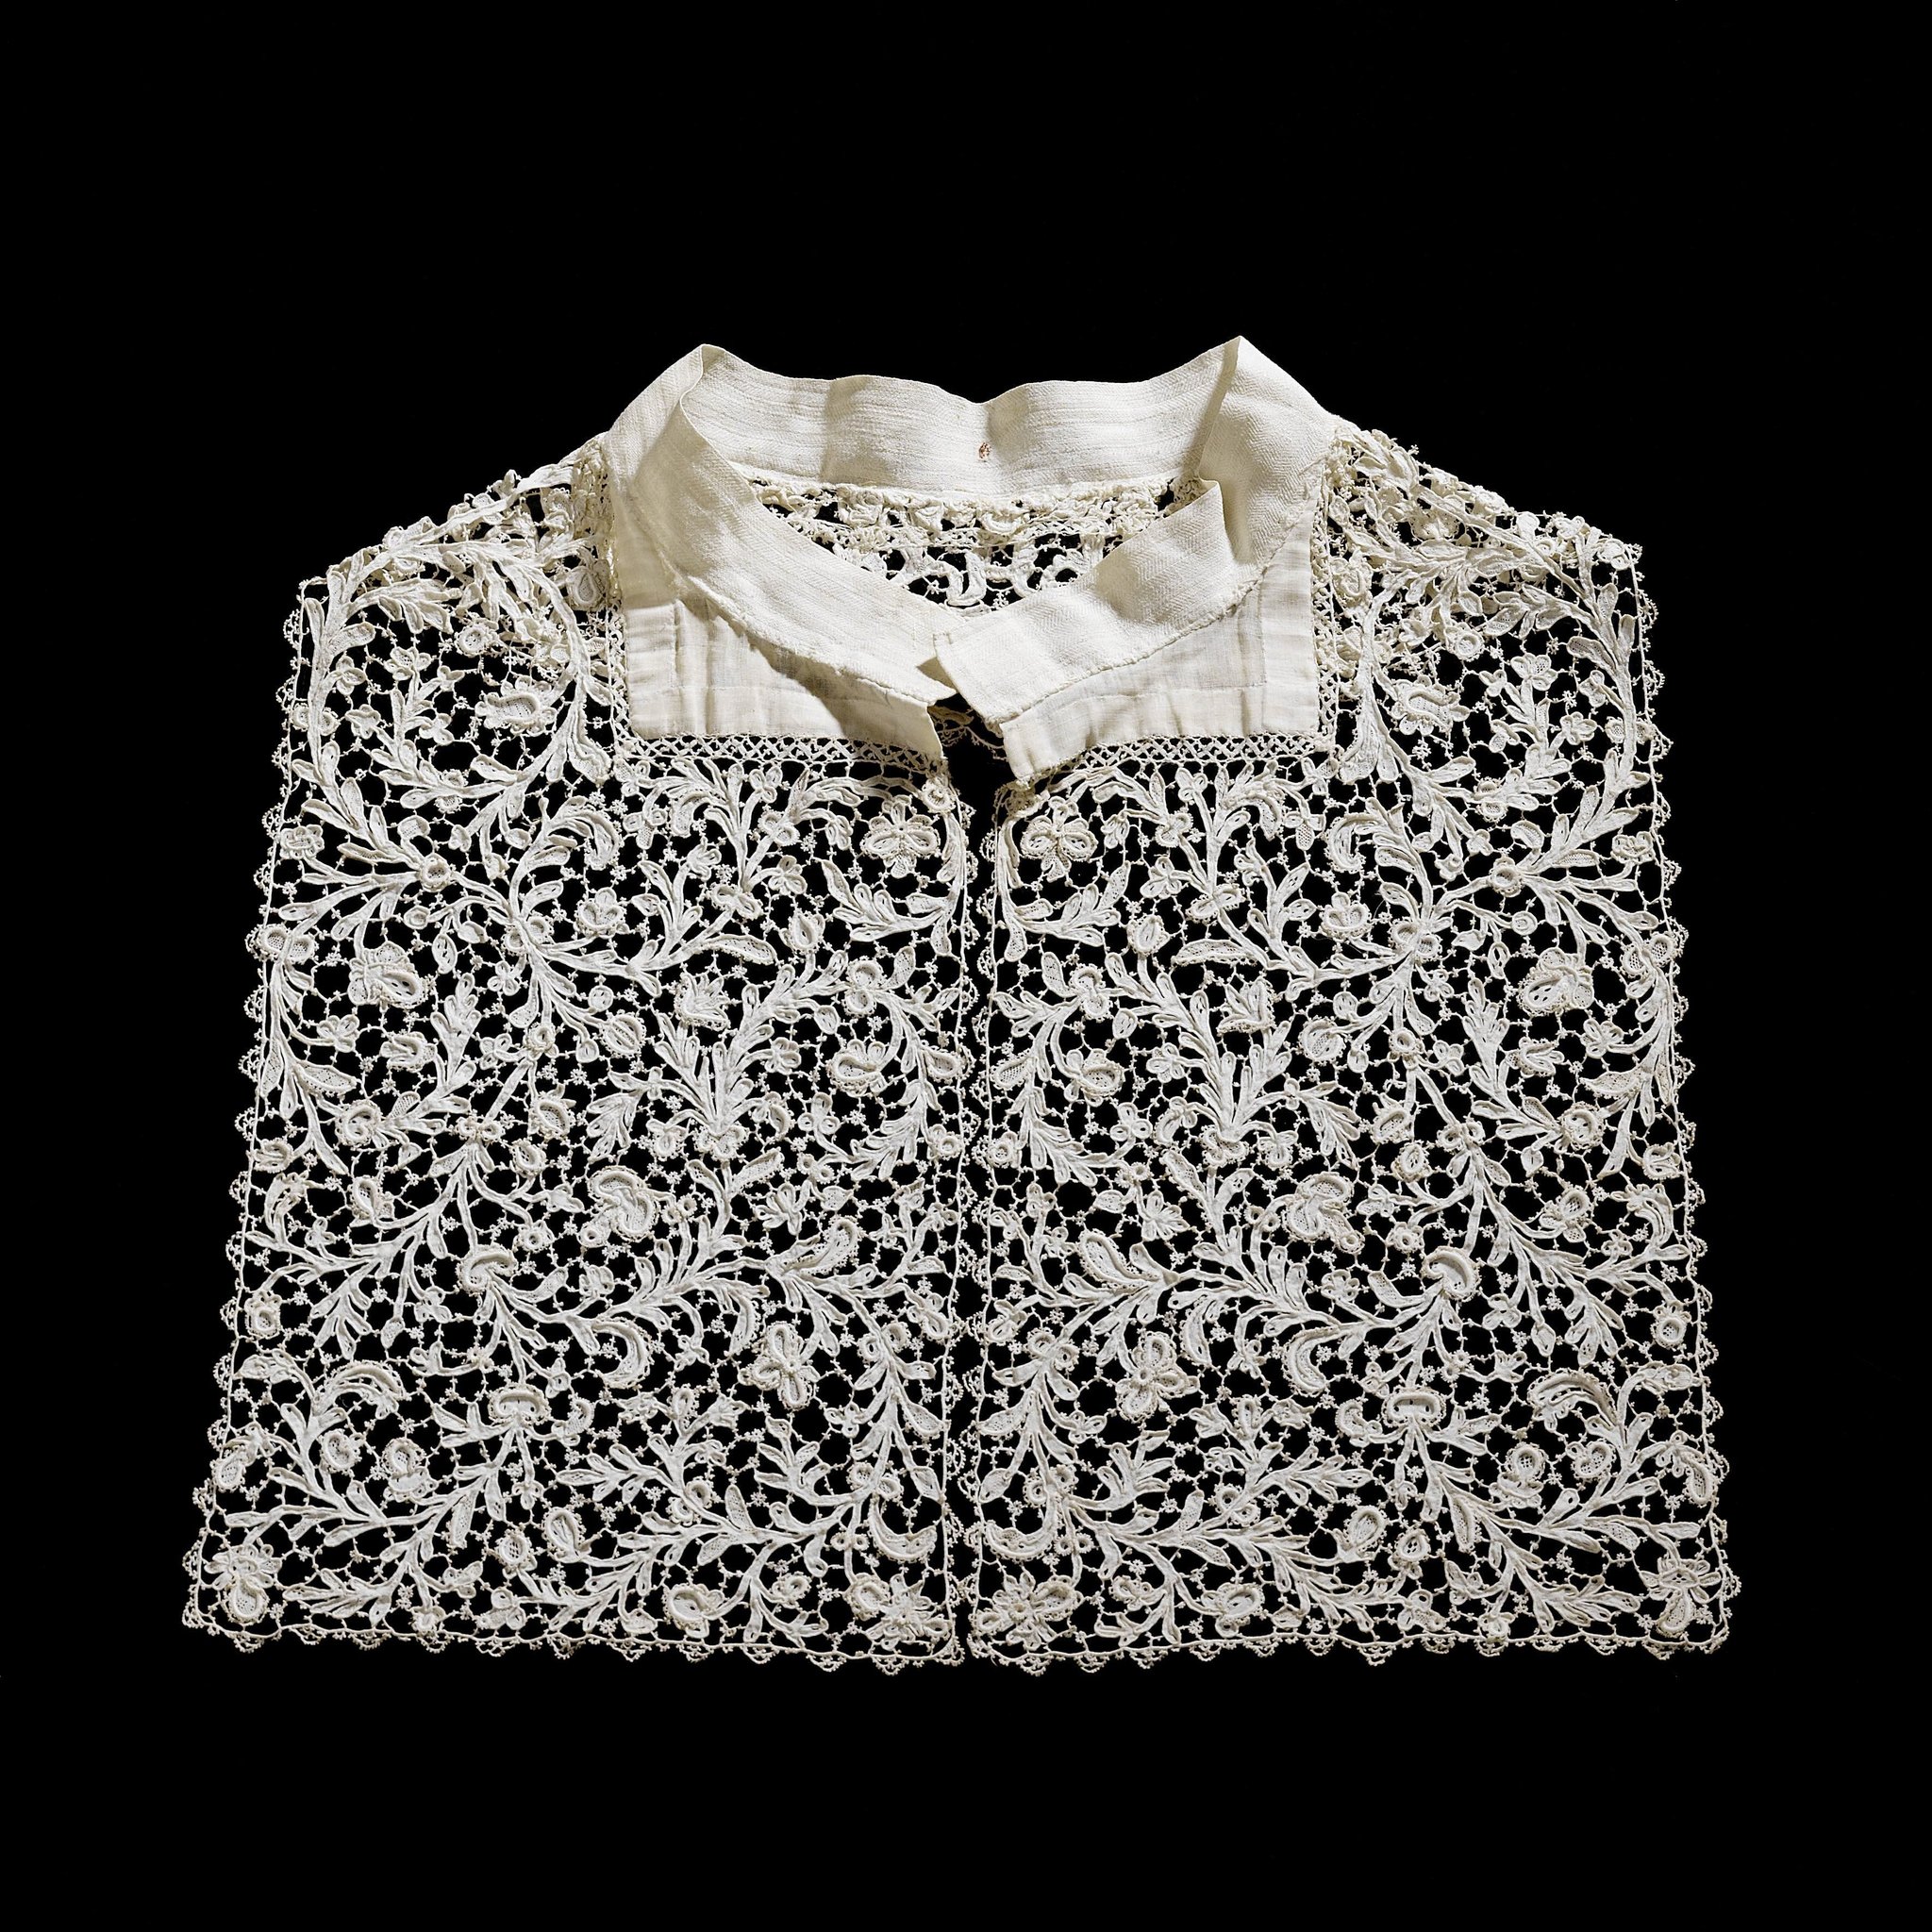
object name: rabat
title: Collar of Venetian Needlepoint Lace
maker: Anonymous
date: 1675-1700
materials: linen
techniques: weave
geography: venice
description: Kraag of rabat van Venetiaans naaldkant met linnen halsstuk. Sluiting middenvoor. Het patroon heeft rijk vertakte, gevederde ranken met bloemknoppen en kleine bloemen in composiet, lelie- en granaatmotief. Hierdoor blijft weinig ruimte meer over voor vulling. De grond is opgebouwd uit stokjes met picots. De kraag is afgezet met een rand van fijne punten, voorzien van picots.